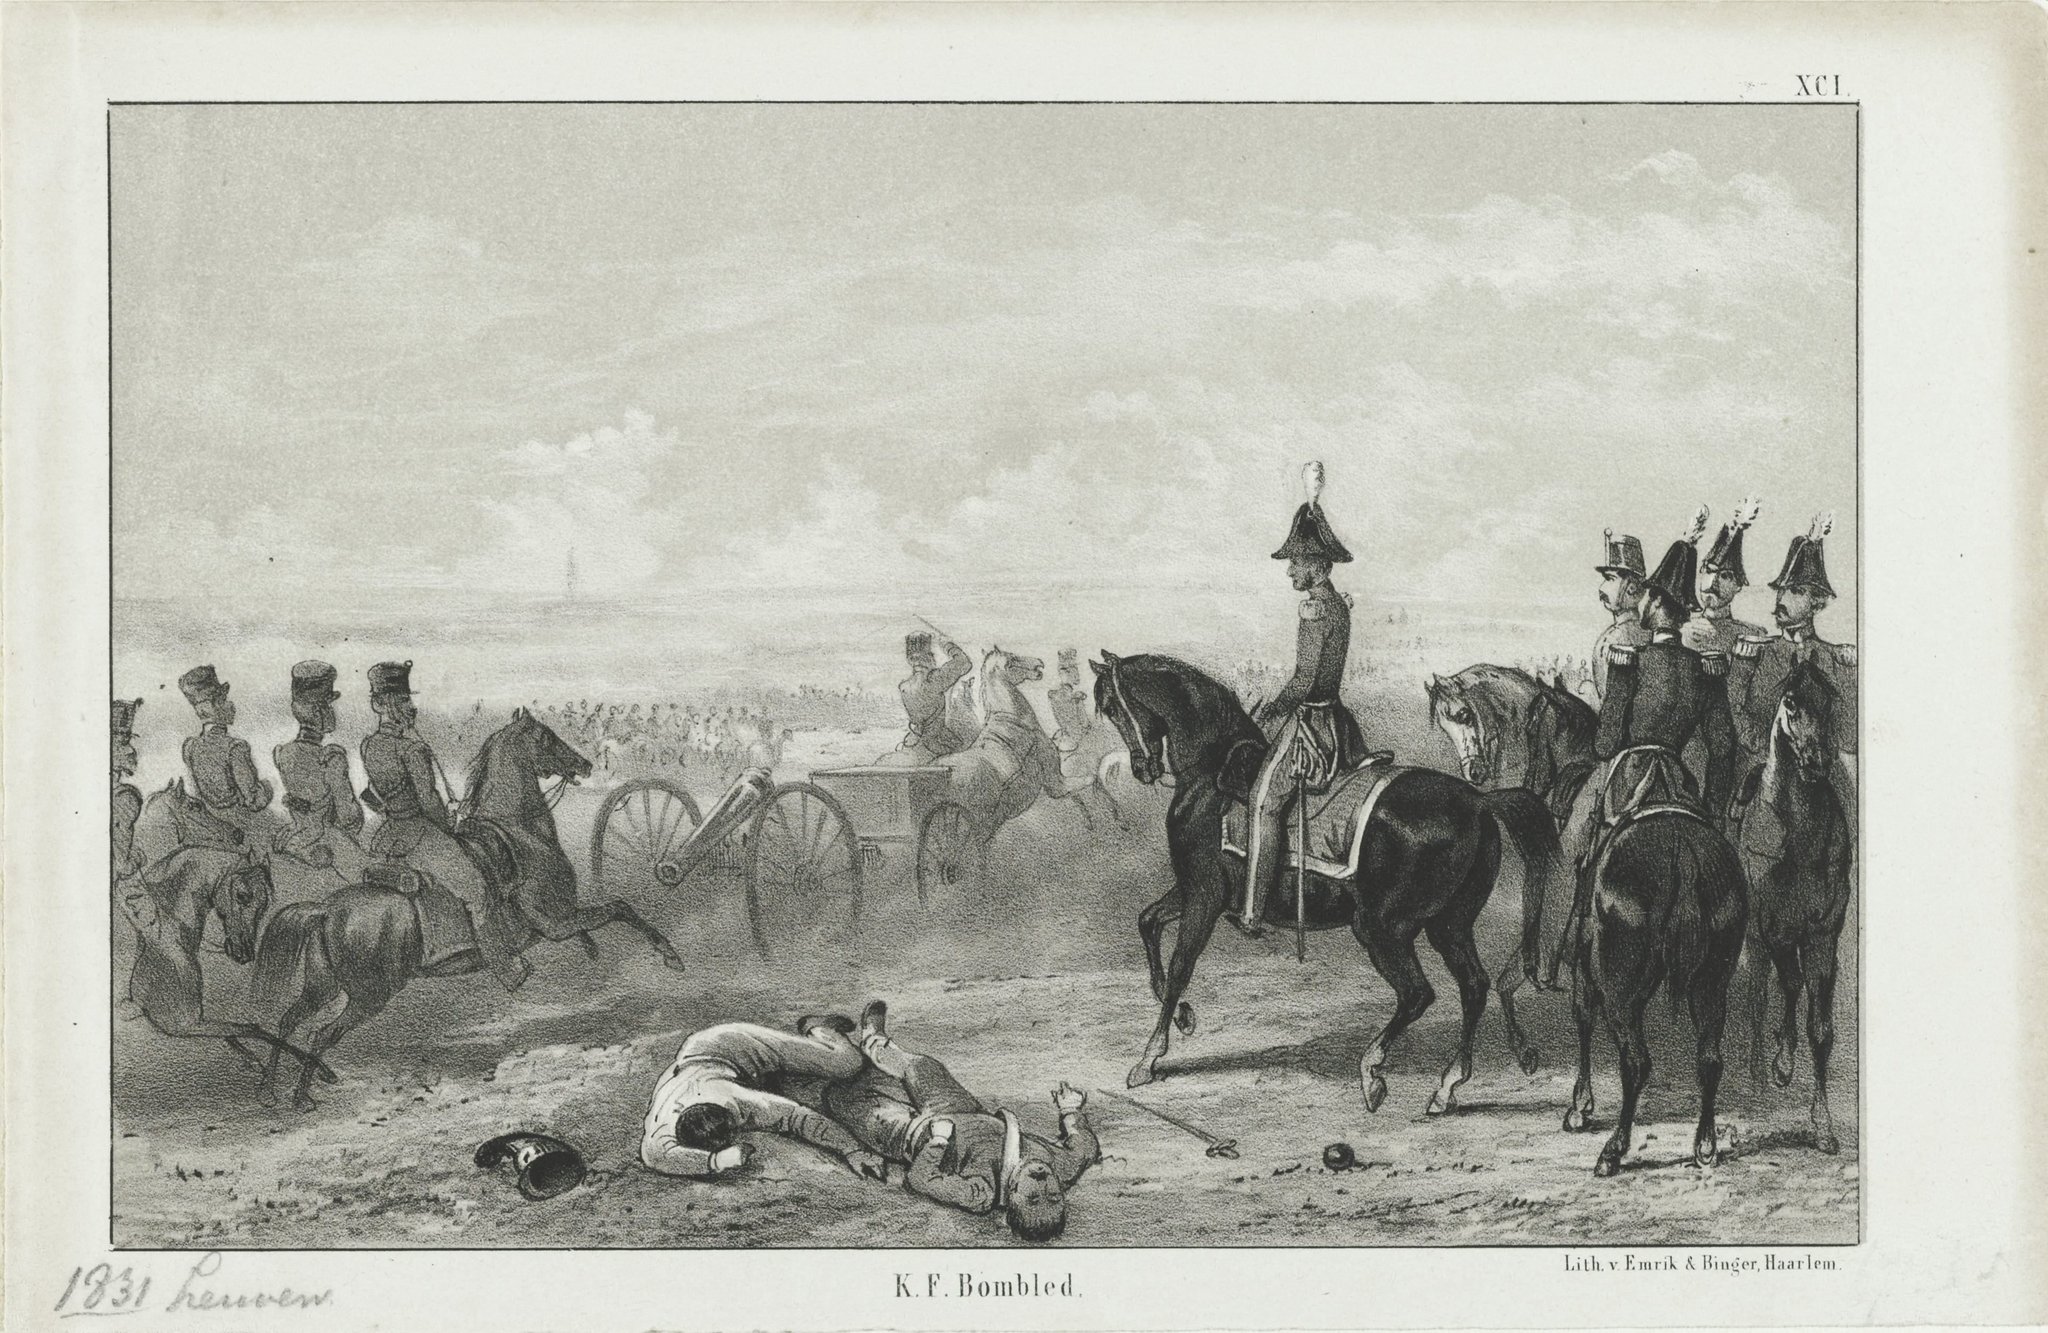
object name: print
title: Slag bij Leuven, 1831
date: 1853-1861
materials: paper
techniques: tone lithography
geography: netherlands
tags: the hague, william ii of the netherlands, battle (+ land forces), louvain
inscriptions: collector's mark: Lugt 2228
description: Dit nummer is een door het RPK toegevoegd nummer en staat niet in Frederik Muller, het werk waar de prent voor is gemaakt of uit afkomstig is, staat wel vermeld in Frederik Muller. Gebruikt als illustratie in: Jacob van Lennep, De geschiedenis des vaderlands in schetsen en afbeeldingen, Binger, Amsterdam 1855-1861, 8 delen, pl. XCI.